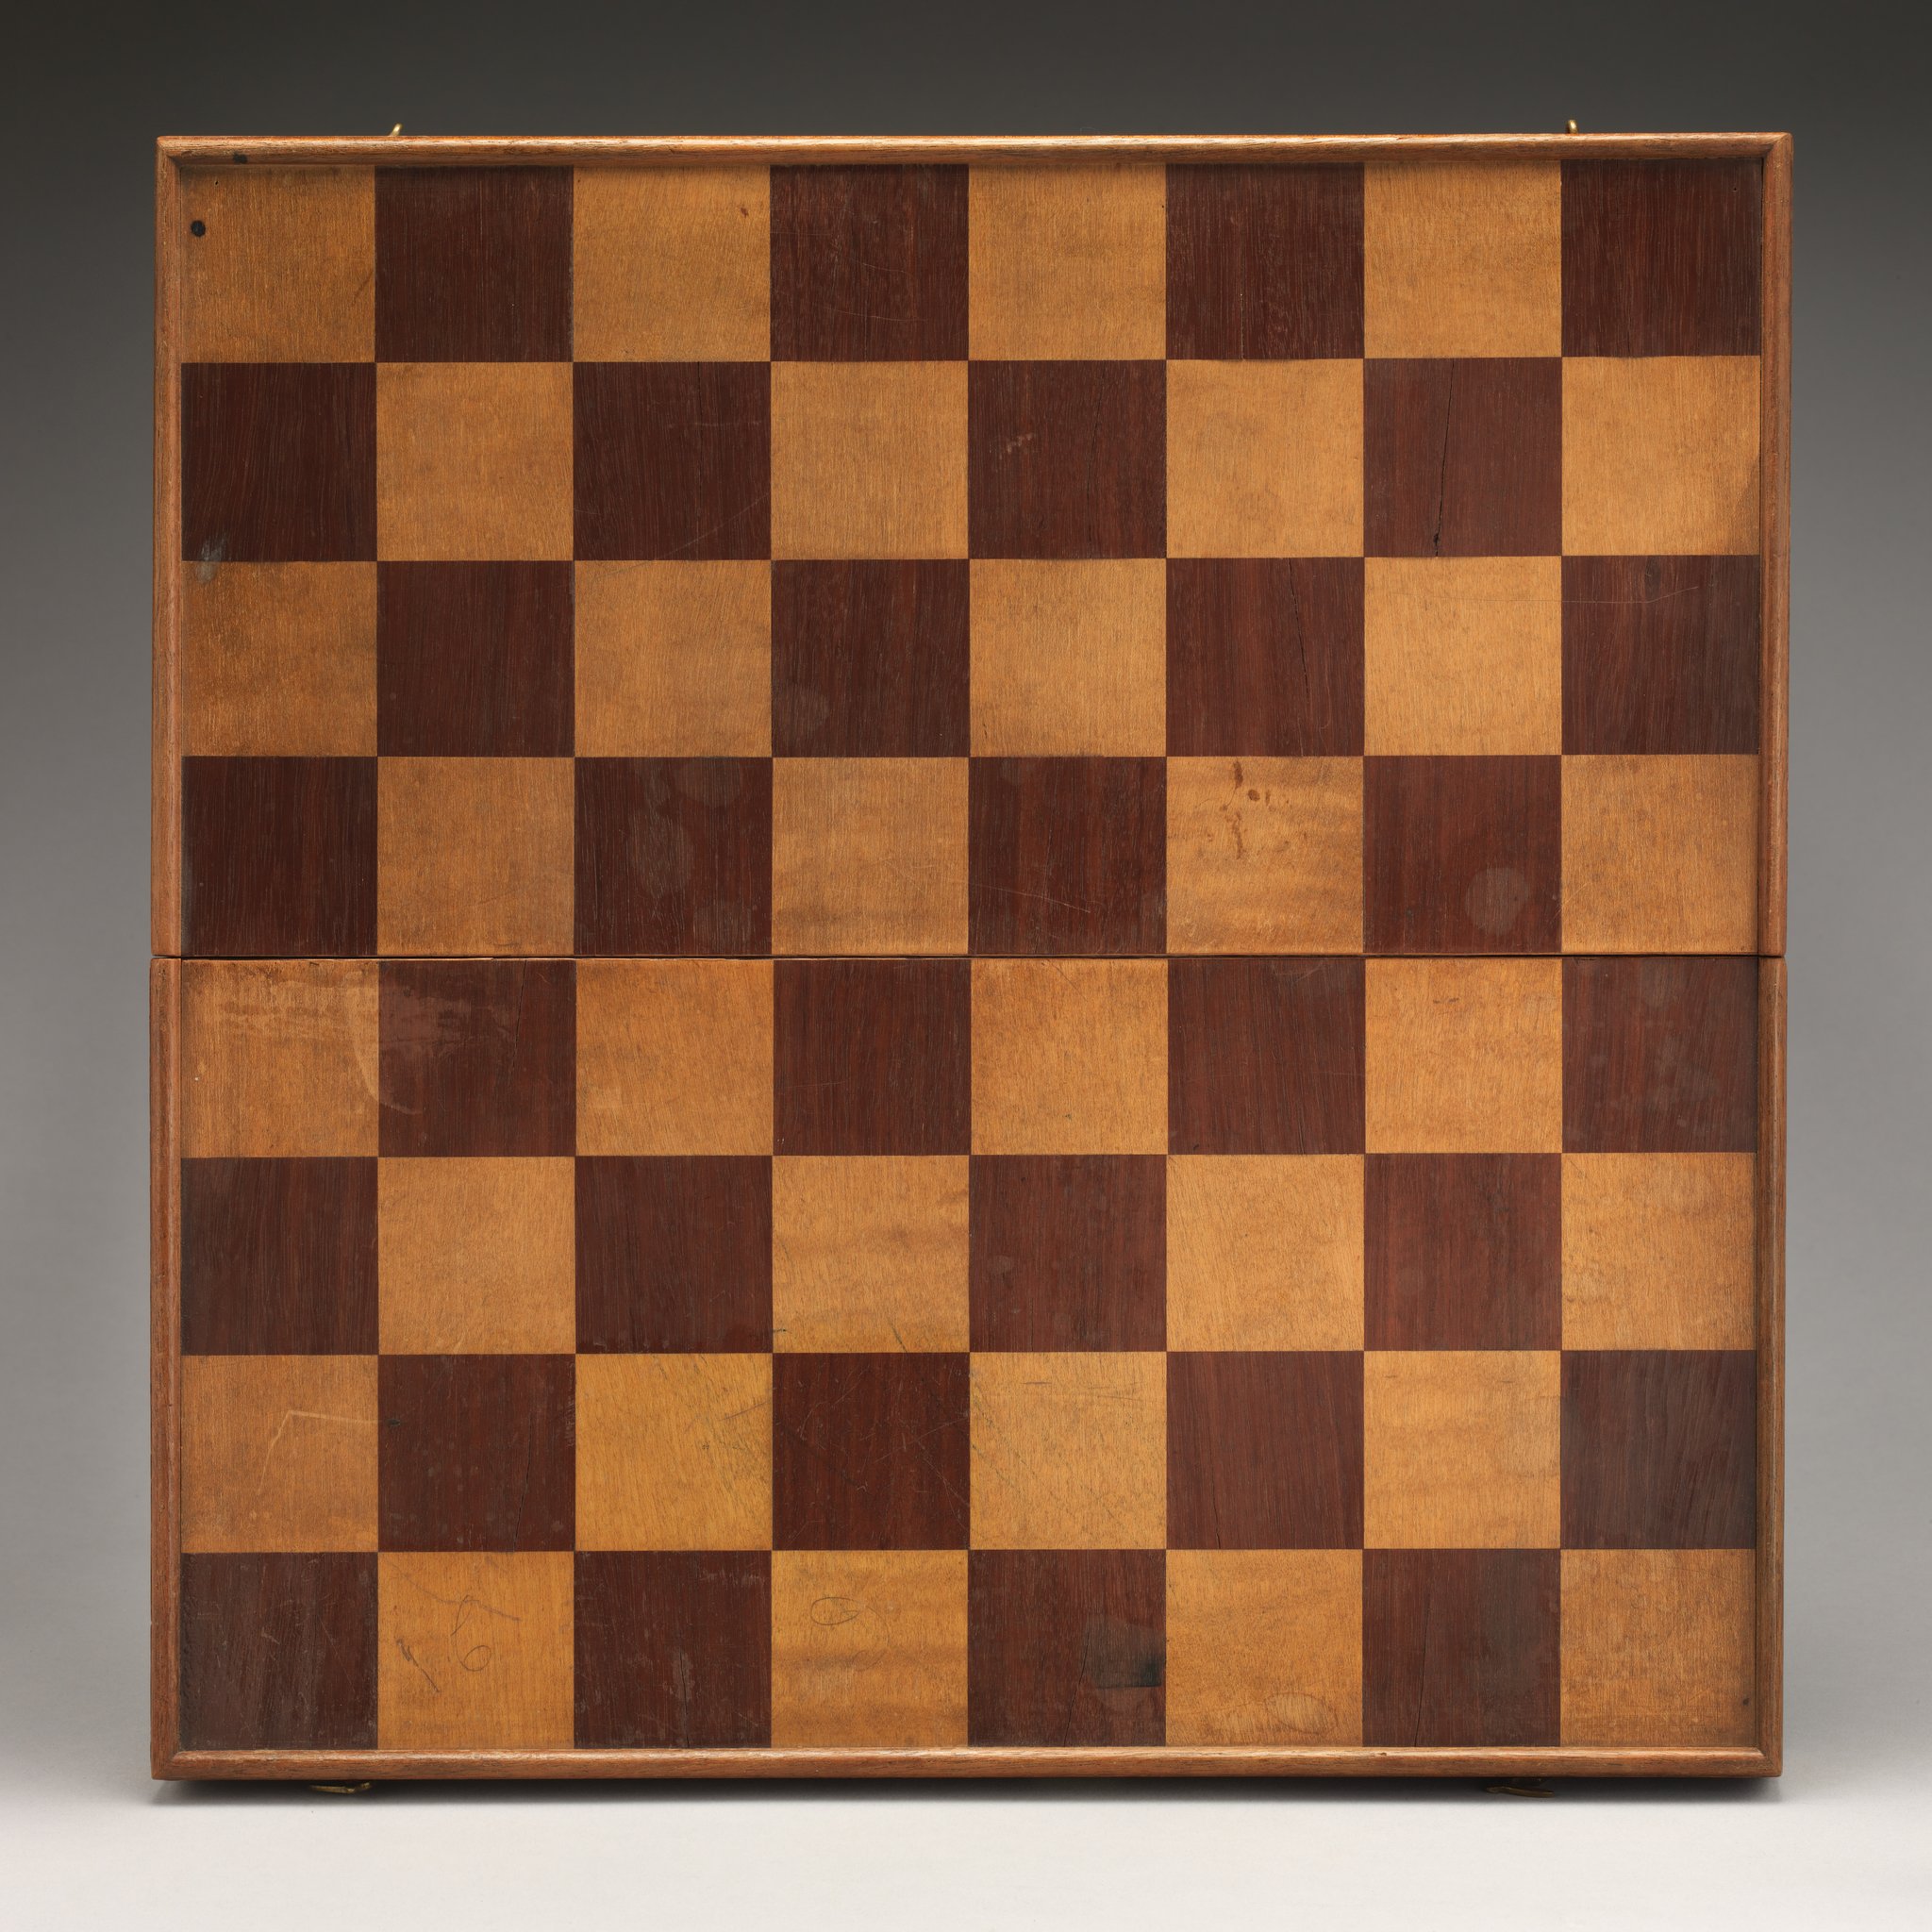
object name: chess and backgammon board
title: Box-board for chess and backgammon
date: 1801-1900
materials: wood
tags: chess